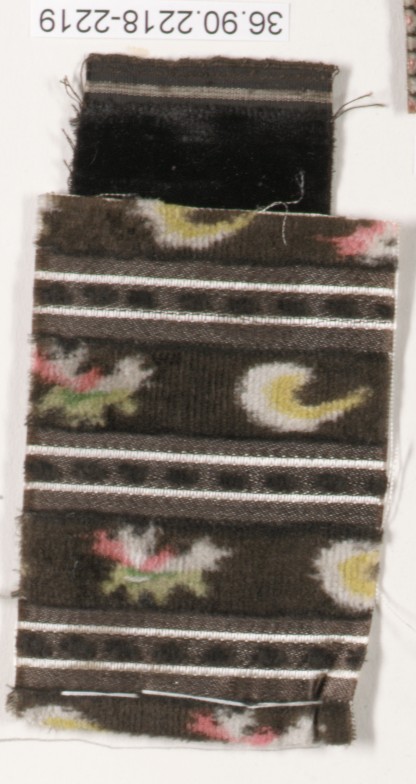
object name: piece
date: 1801-1900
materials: silk